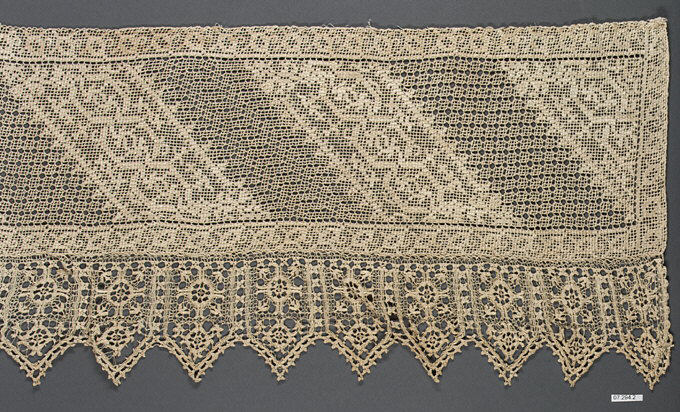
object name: border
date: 1601-1700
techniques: embroidery